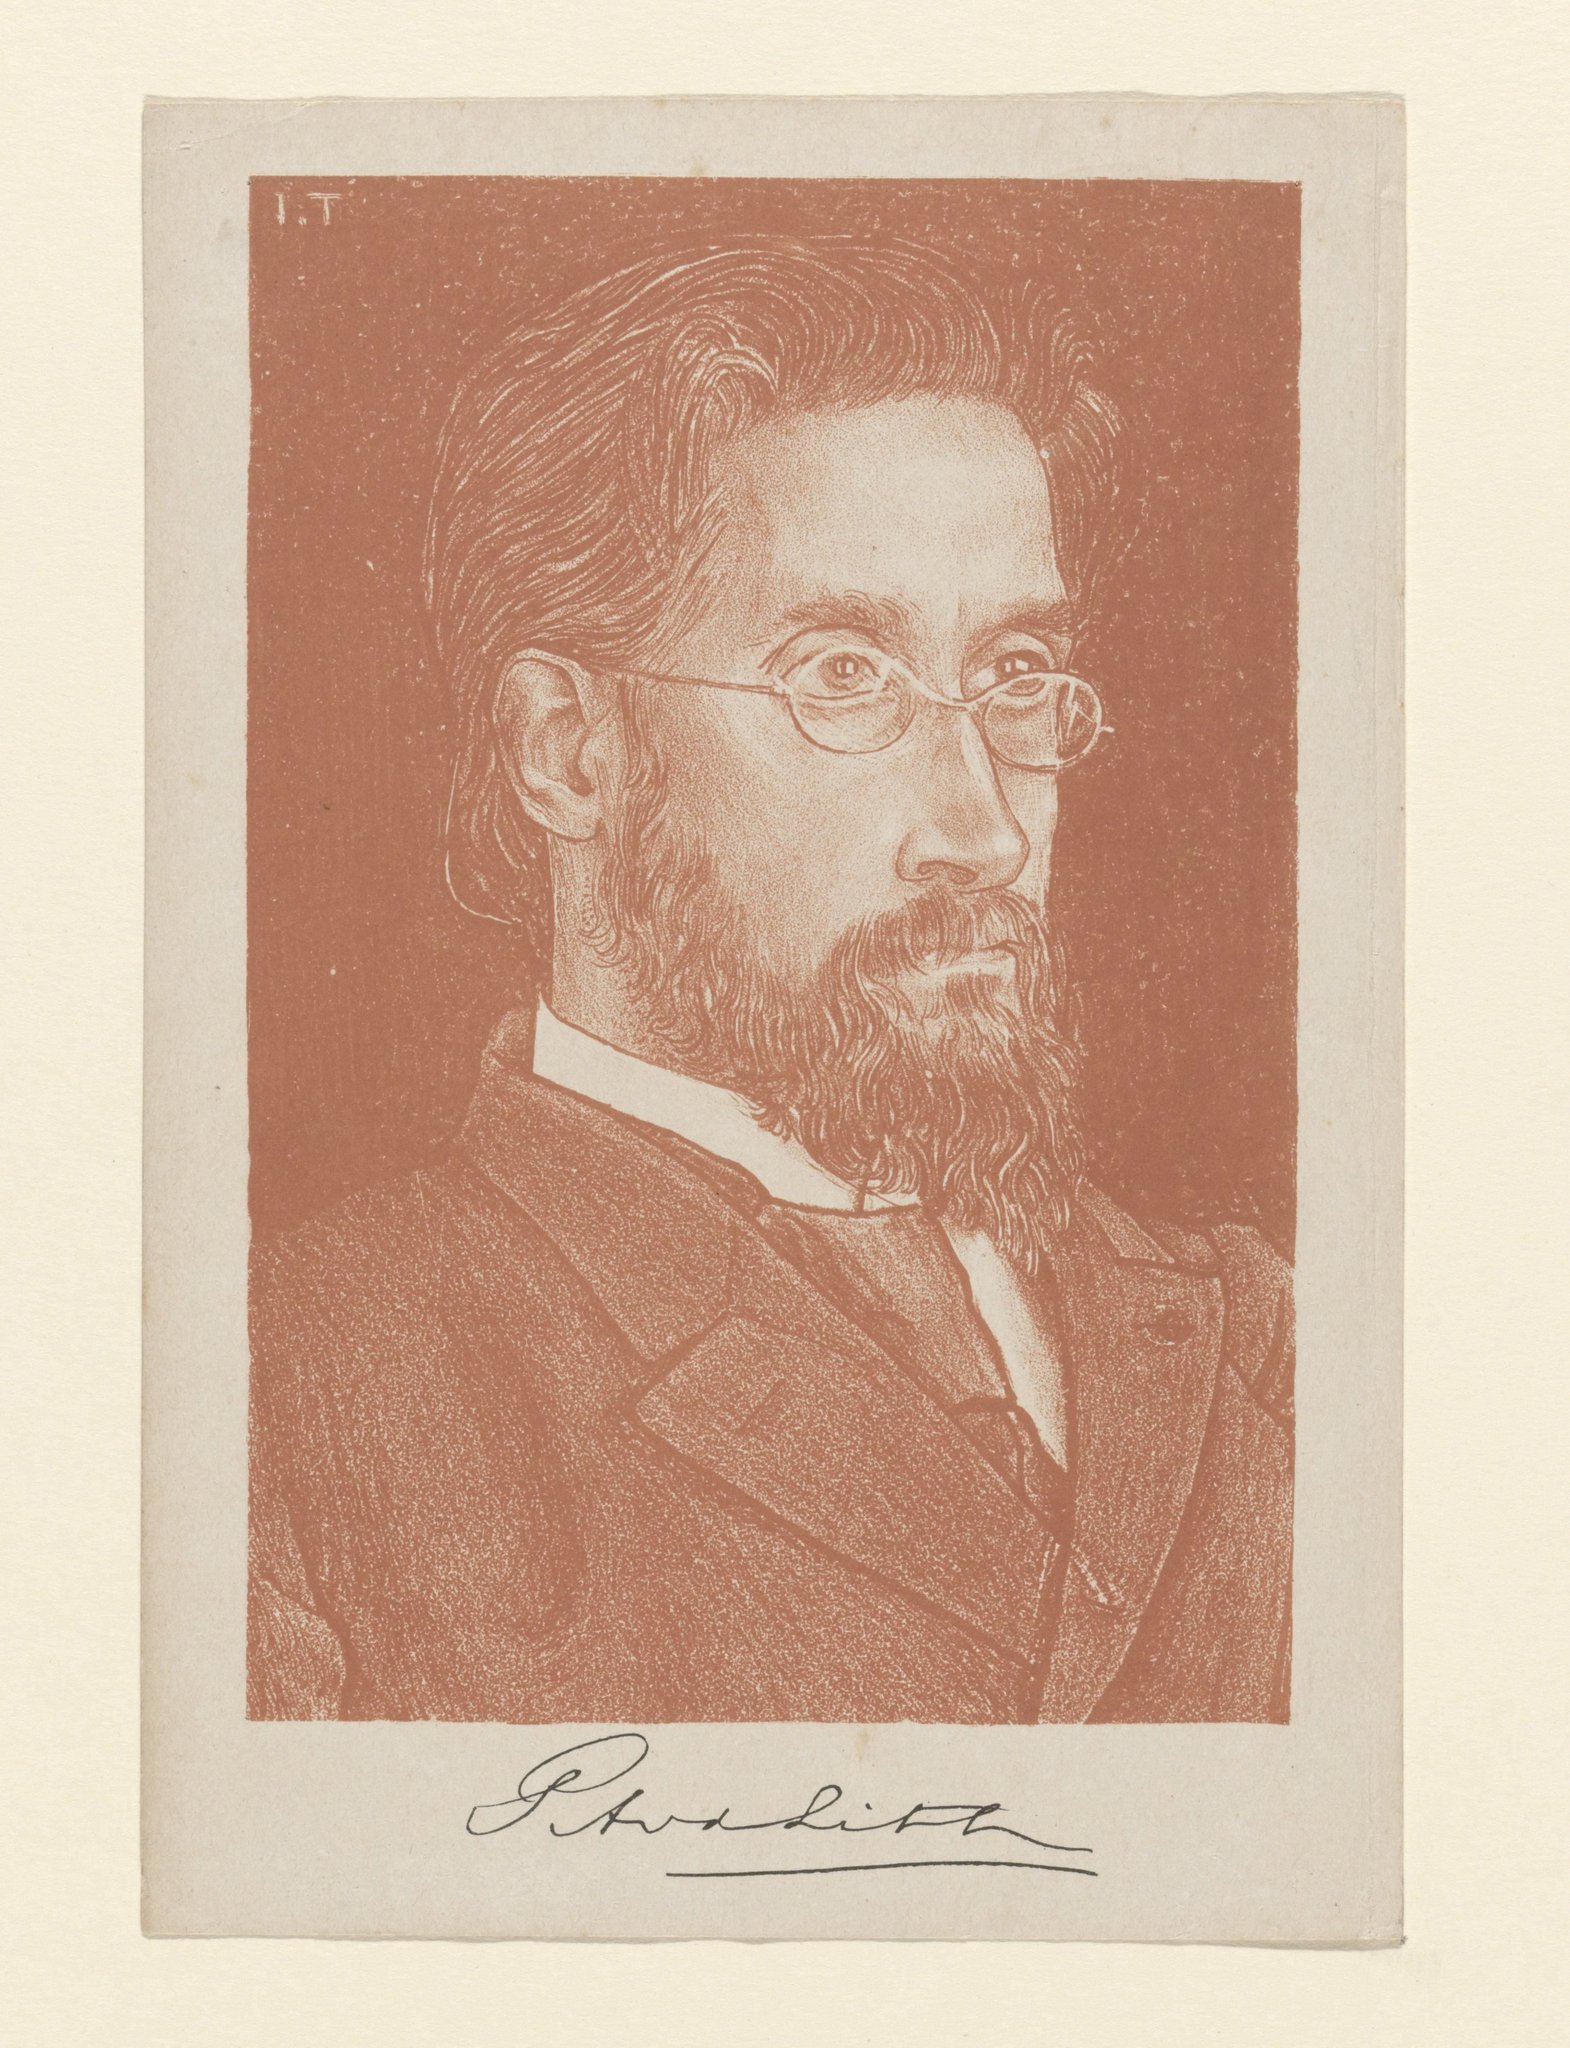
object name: print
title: Portret van Pieter Anthonie van der Lith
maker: jan toorop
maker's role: draughtsman, painter, print maker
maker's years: 1858-1928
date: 1894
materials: paper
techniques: lithograph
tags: historical persons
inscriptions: collector's mark: Lugt 2228